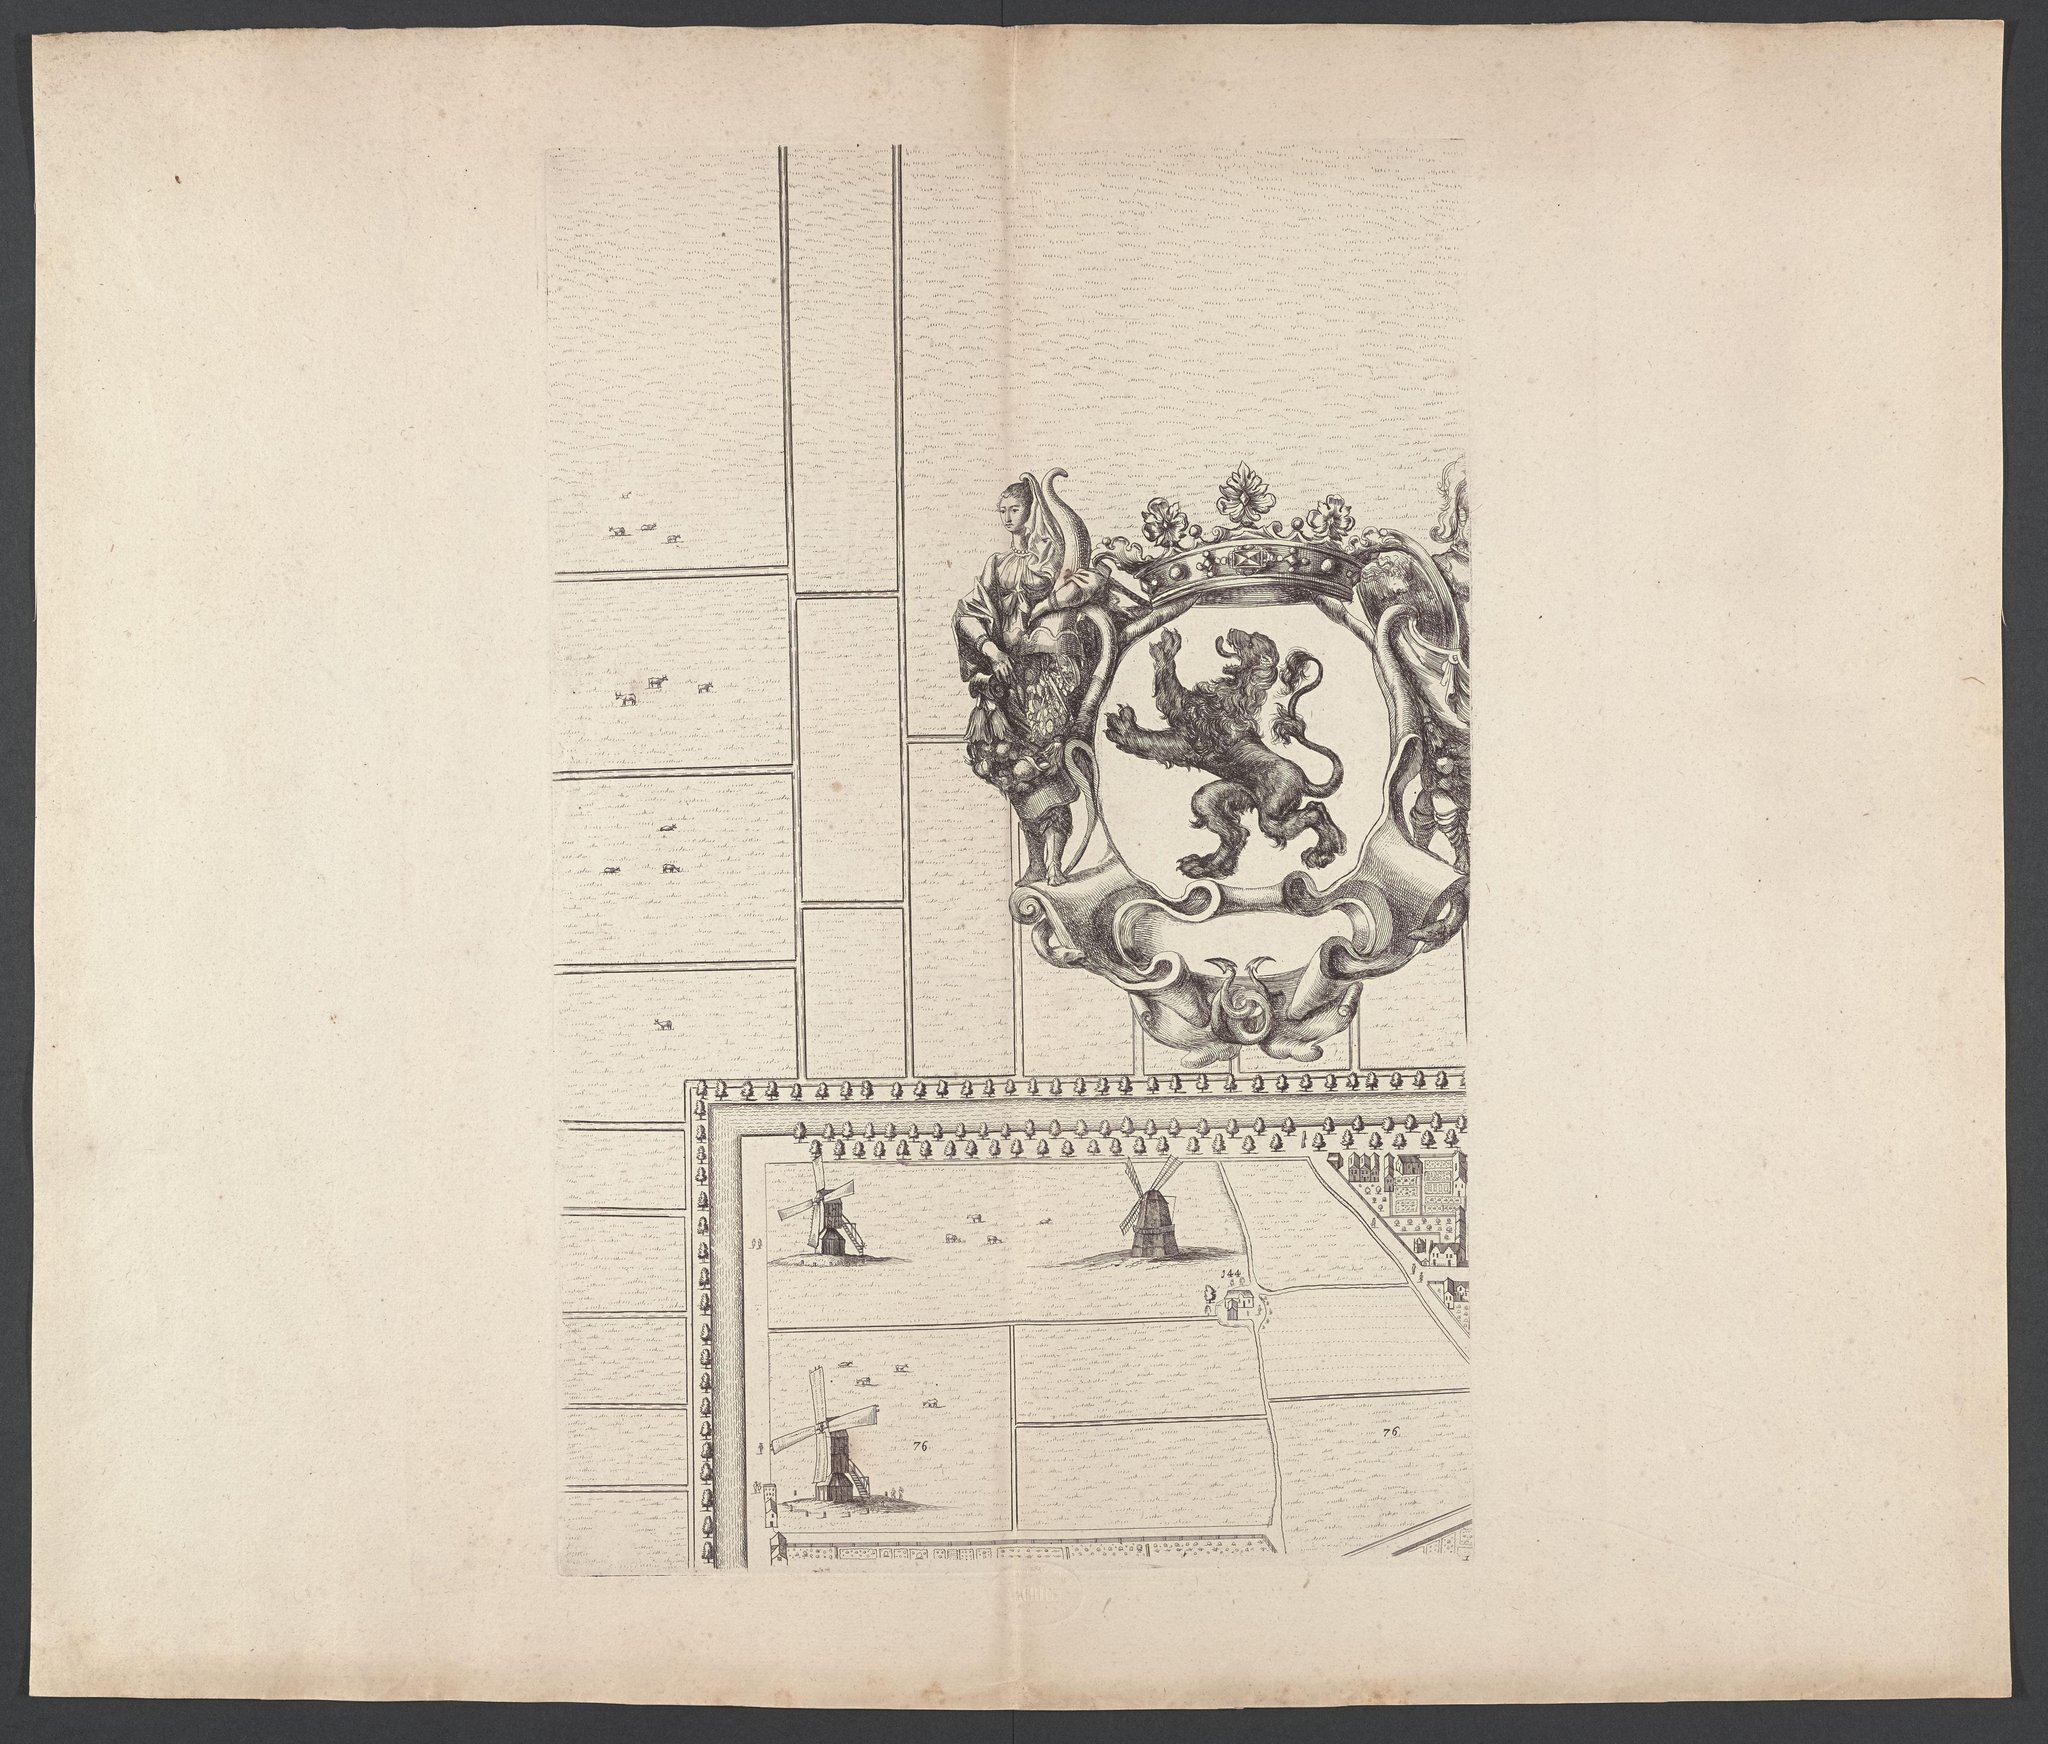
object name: area plan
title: Plattegrond van de figuratieve kaart van Den Haag (eerste deel)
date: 1665-1667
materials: paper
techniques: etching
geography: amsterdam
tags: maps of cities, coat of arms (as symbol of the state, etc.) (+ province; provincial), the hague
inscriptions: collector's mark: Lugt 2228, check stamp: ‘Archief Ministerie van Oorlog Afdeeling Genie’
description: Deze prent is onderdeel van een plattegrond van Den Haag. Deze staat van de plattegrond werd oorspronkelijk uitgegeven met een sierrand, bestaande uit een gezicht op de stad en veertien kleinere gezichten in en om Den Haag, en vormde zo de zogenaamde figuratieve kaart van Den Haag. Voor de prenten die de rand vormen, zie: RP-P-AO-12-8, RP-P-AO-12-8-2, RP-P-OB-50.201, RP-P-OB-50.202, RP-P-OB-50.203, RP-P-OB-50.204, RP-P-OB-50.205, RP-P-OB-50.206, RP-P-OB-50.207, RP-P-OB-50.208, RP-P-OB-102.387, RP-P-OB-50.209, RP-P-OB-50.210, RP-P-OB-50.211, RP-P-OB-50.212, RP-P-OB-50.213, RP-P-AO-12-5-4 en RP-P-OB-50.214.